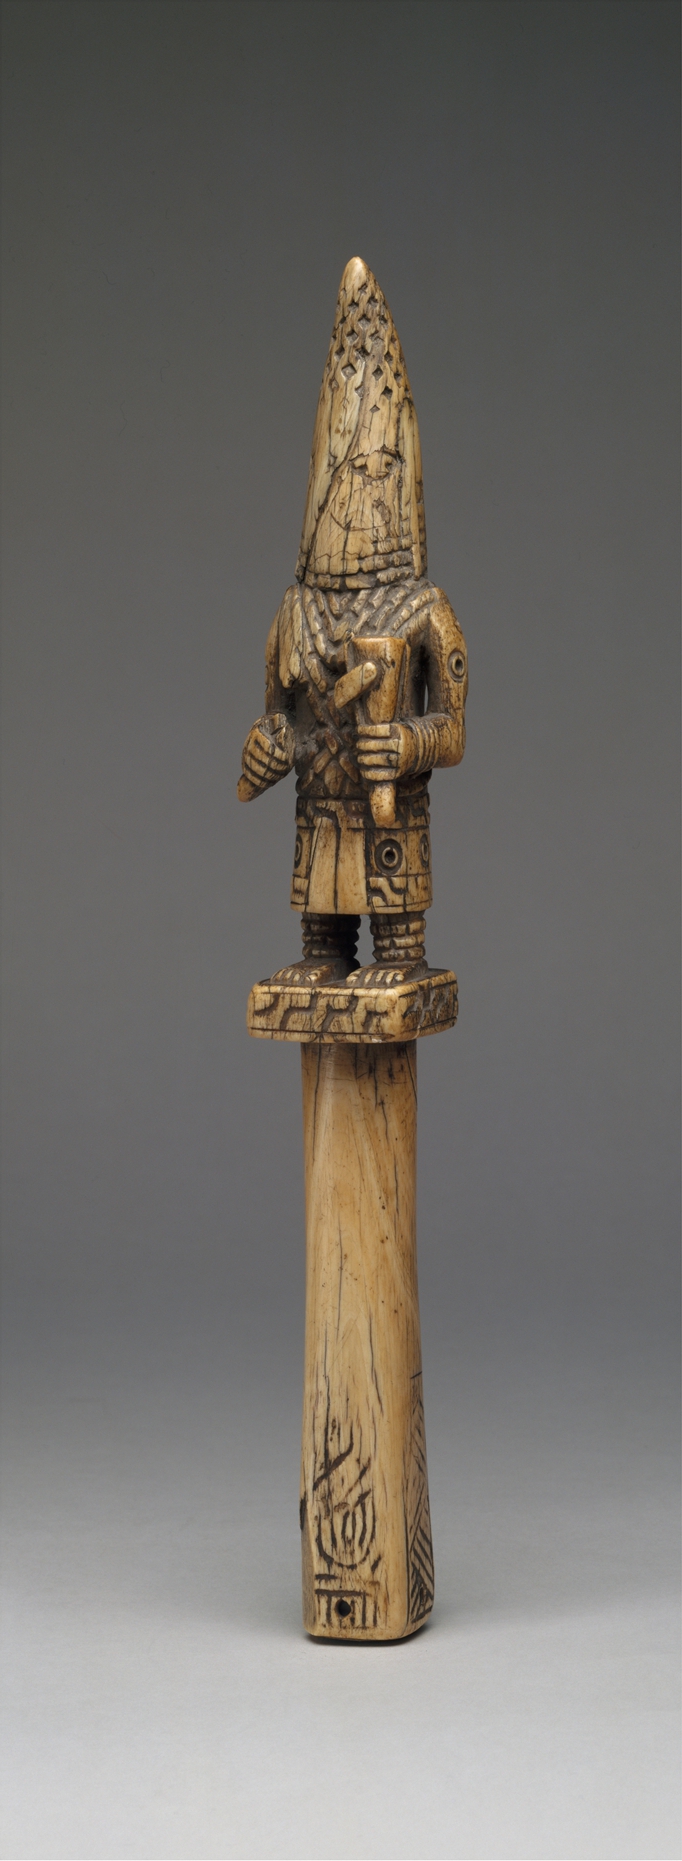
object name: idiophone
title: Idiophone with an iyọ́bà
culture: edo period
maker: ìgbèsànmwà (ivory- and wood- carving guild) artists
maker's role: artist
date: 1701-1900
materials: ivory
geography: nigeria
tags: musical instruments,men